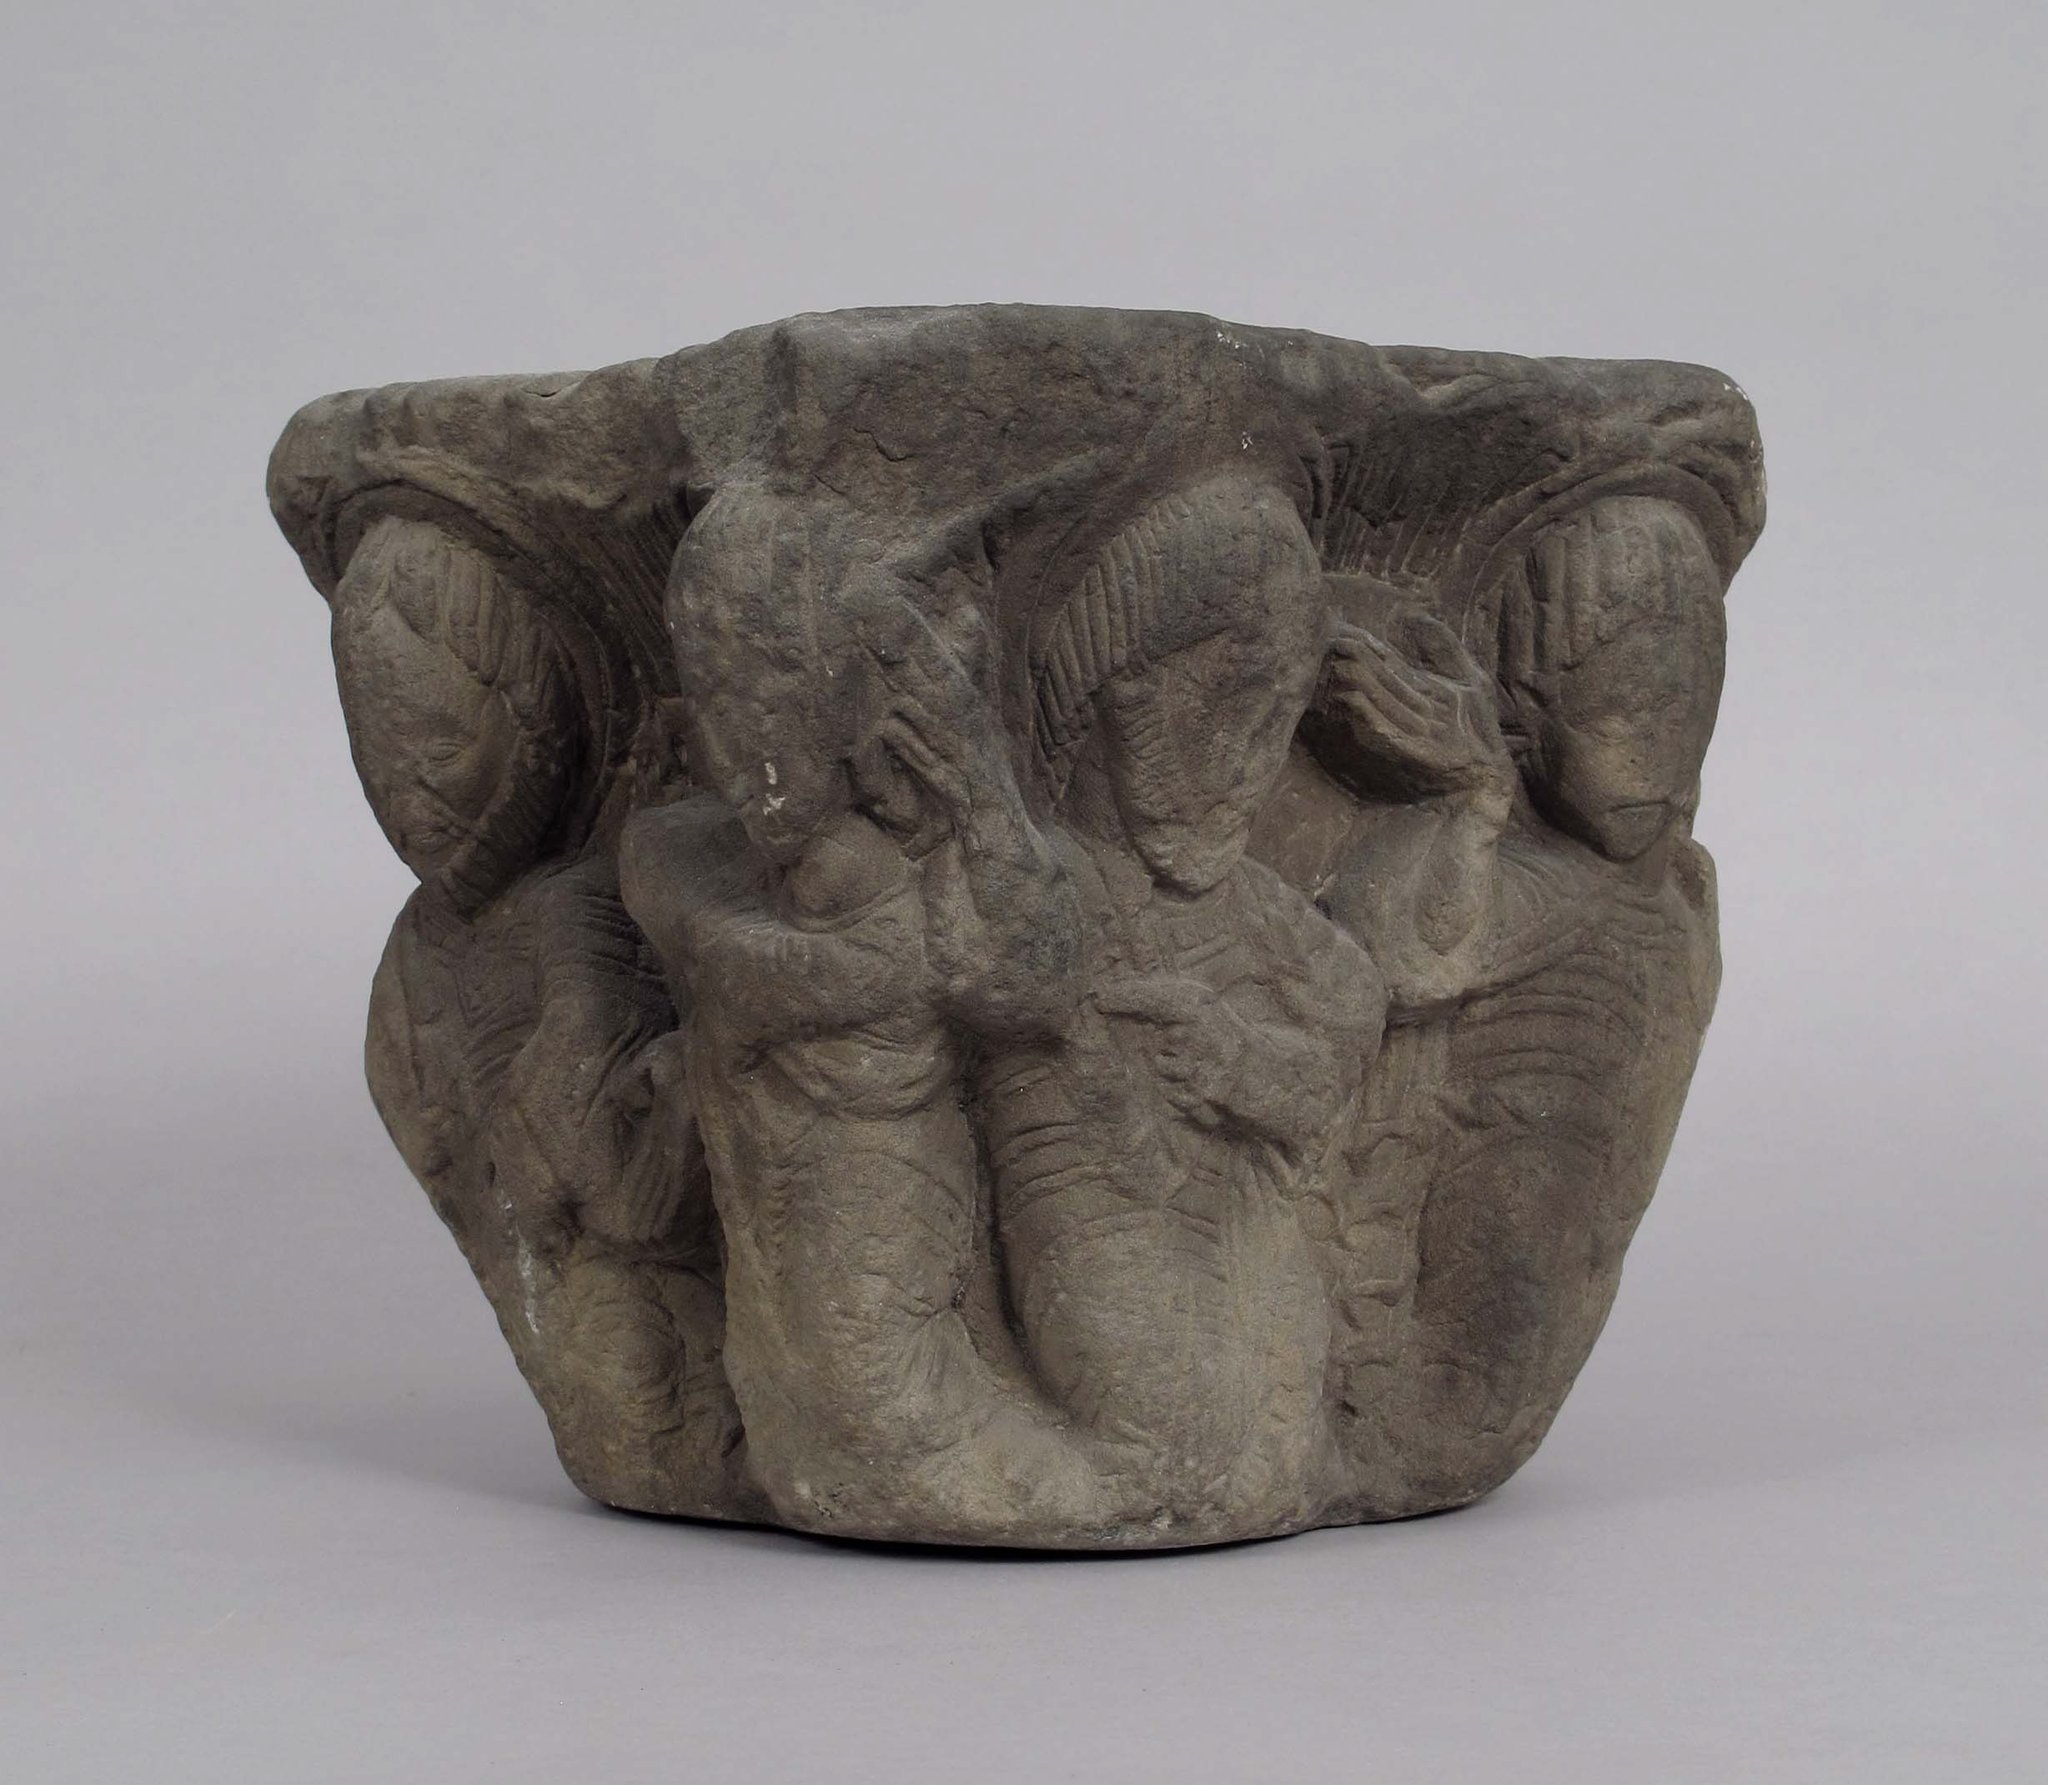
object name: capital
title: Capital with Christ Giving the Keys to Saint Peter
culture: french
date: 1150-1200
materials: limestone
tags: christ,saint peter